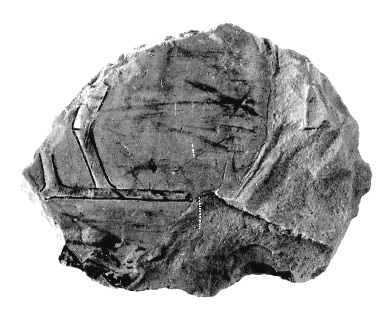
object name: relief fragment, tomb of meketre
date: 1981-1975 BCE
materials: limestone, paint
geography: egypt